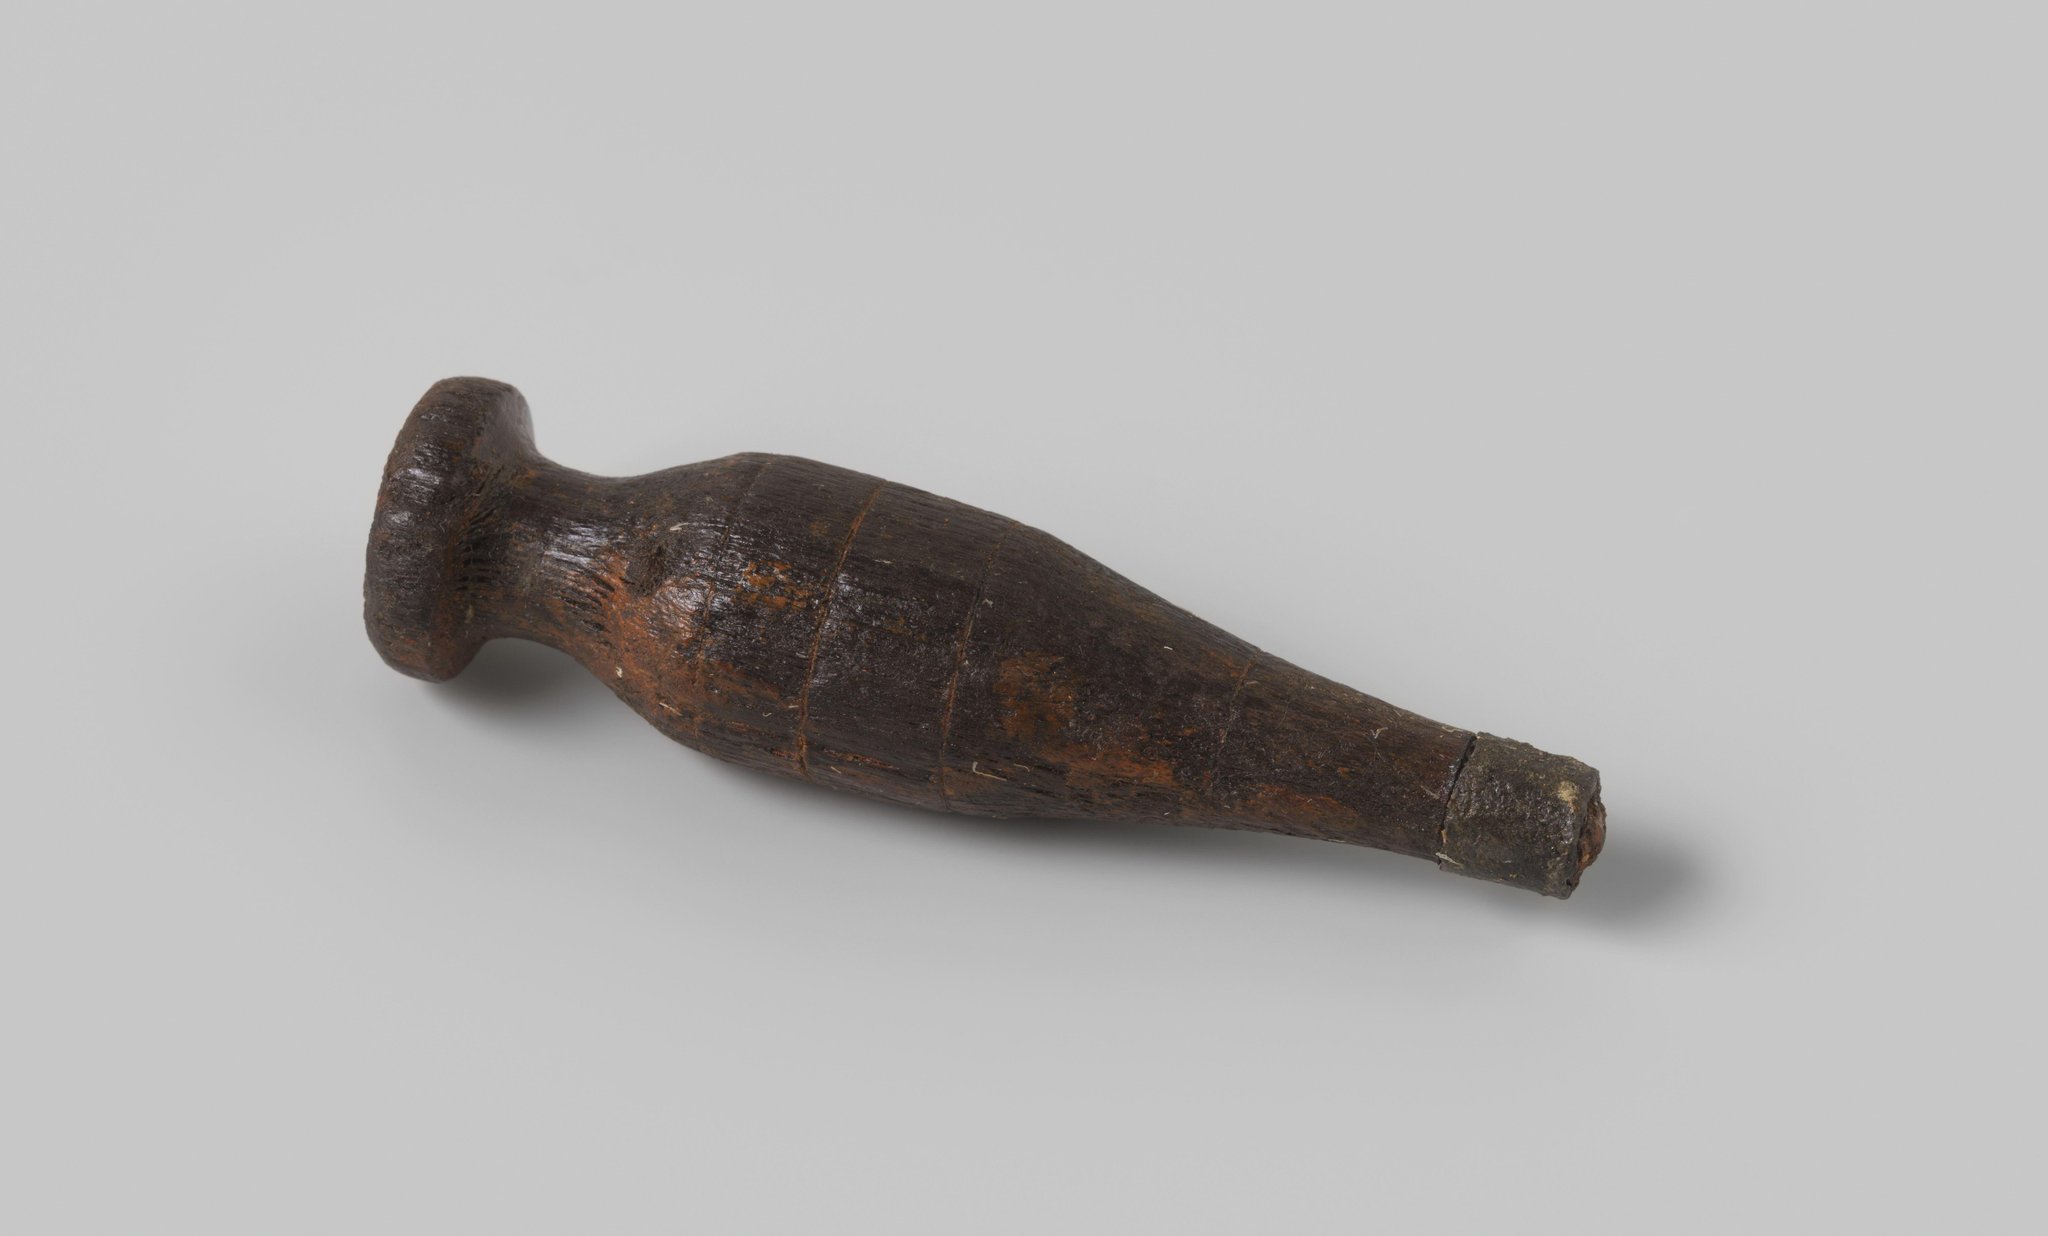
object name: awl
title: Handvat van een priem of een beitel uit het wrak van de Oost-Indiëvaarder Hollandia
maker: Anonymous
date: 1700-1743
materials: wood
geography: netherlands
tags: verenigde oostindische compagnie, hollandia (schip), annet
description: Tools and instruments, various tools, awl/chisel handle; oblong, circular in section, bulbous central part, flat wide disc-shaped upper end, ferrule around lower end, linear concentric engravings